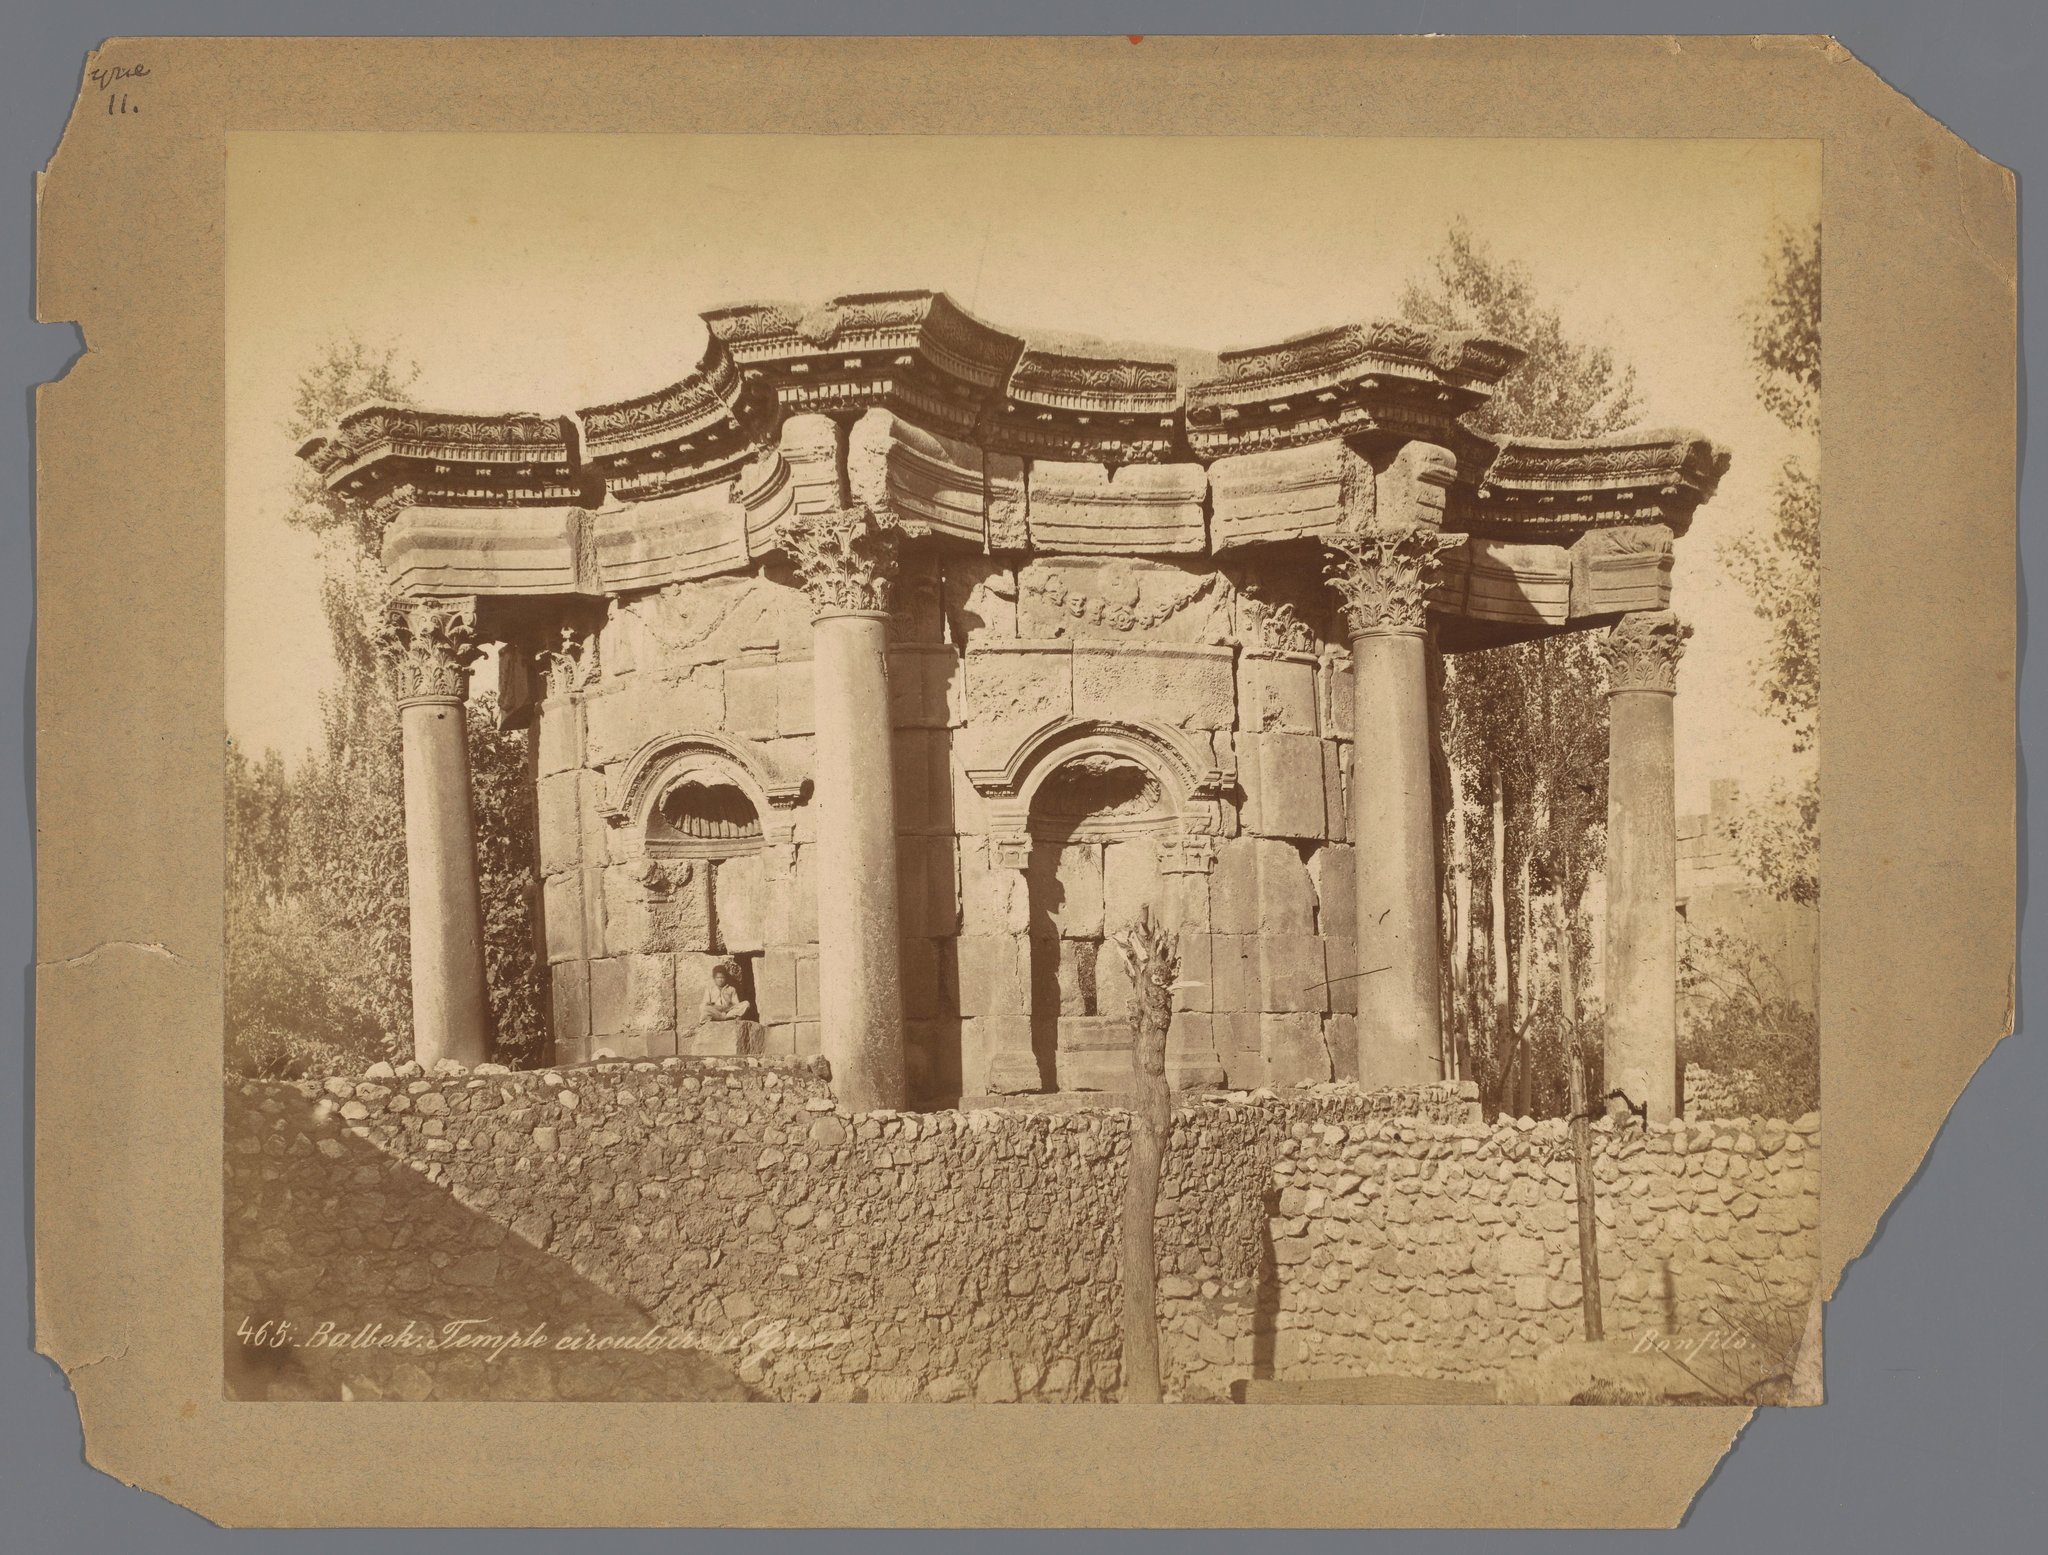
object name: photograph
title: Temple circulaire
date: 1850-1900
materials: cardboard, photographic support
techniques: albumen print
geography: baalbek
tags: temple, shrine ~ roman religion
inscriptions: number: ‘Syrie 11’, number: ‘465’, collector's mark: ‘Rijks-normaalschool voor teekenonderwijzers Amsterdam’ Lugt 3937